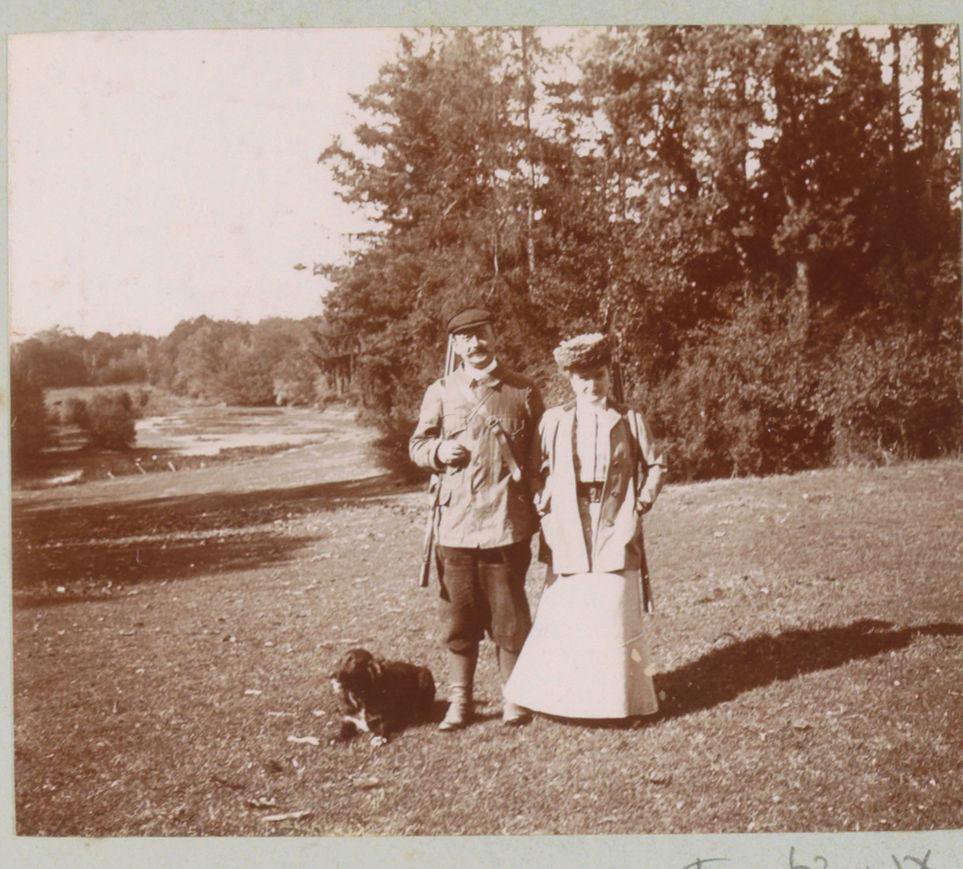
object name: photograph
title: Een vrouw, een man met een jachtgeweer en een hond, vermoedelijk in Frankrijk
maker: delizy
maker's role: manufacturer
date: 1904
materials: paper, photographic support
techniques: gelatin silver print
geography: france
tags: adult woman, hunting dogs, hunter, adult man, france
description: Onderdeel van Fotoalbum van een Franse amateurfotograaf met opnames van uitstapjes in Frankrijk, Spanje, België, Luxemburg en Nederland, de eerste automobielen en autoraces.